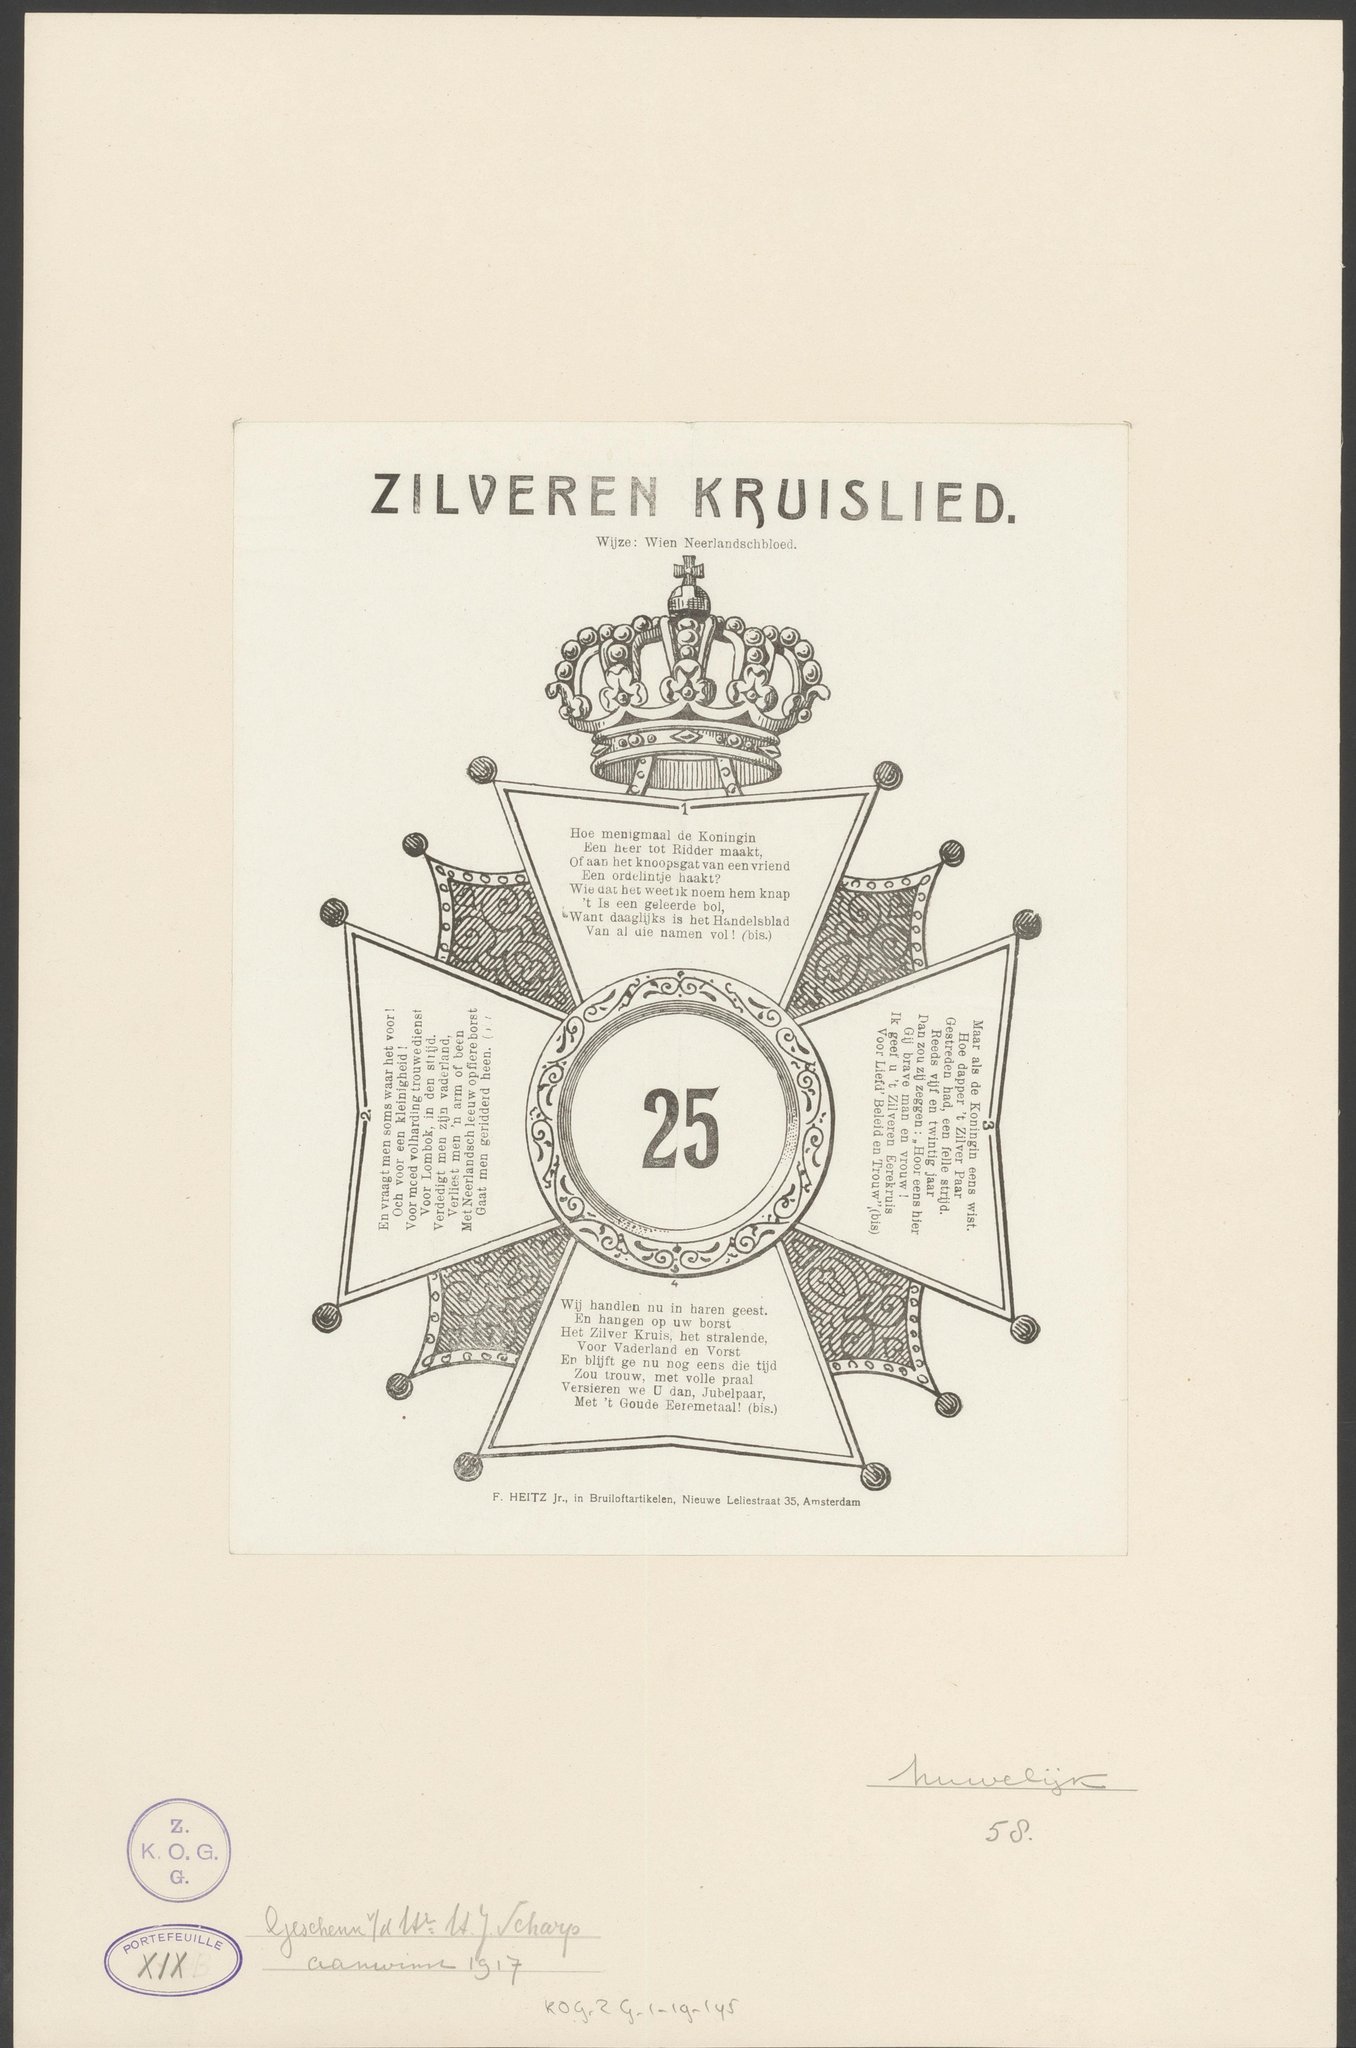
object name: print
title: Zilveren Kruislied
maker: frans heitz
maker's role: winkelier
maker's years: 1864-1941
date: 1900-1917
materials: paper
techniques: lithograph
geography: amsterdam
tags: silver anniversary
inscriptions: collector's mark: Lugt 1641, collector's mark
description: Zilveren Kruislied, lied te zingen ter gelegenheid van een zilveren huwelijksjubileum. In de vorm van een onderscheiding met vier verzen. Onderwerpsrubrieken binnen de Atlas Zeden en Gewoonten: Des Menschen Begin, Midden en Einde. Bruiloft en huwelijk.